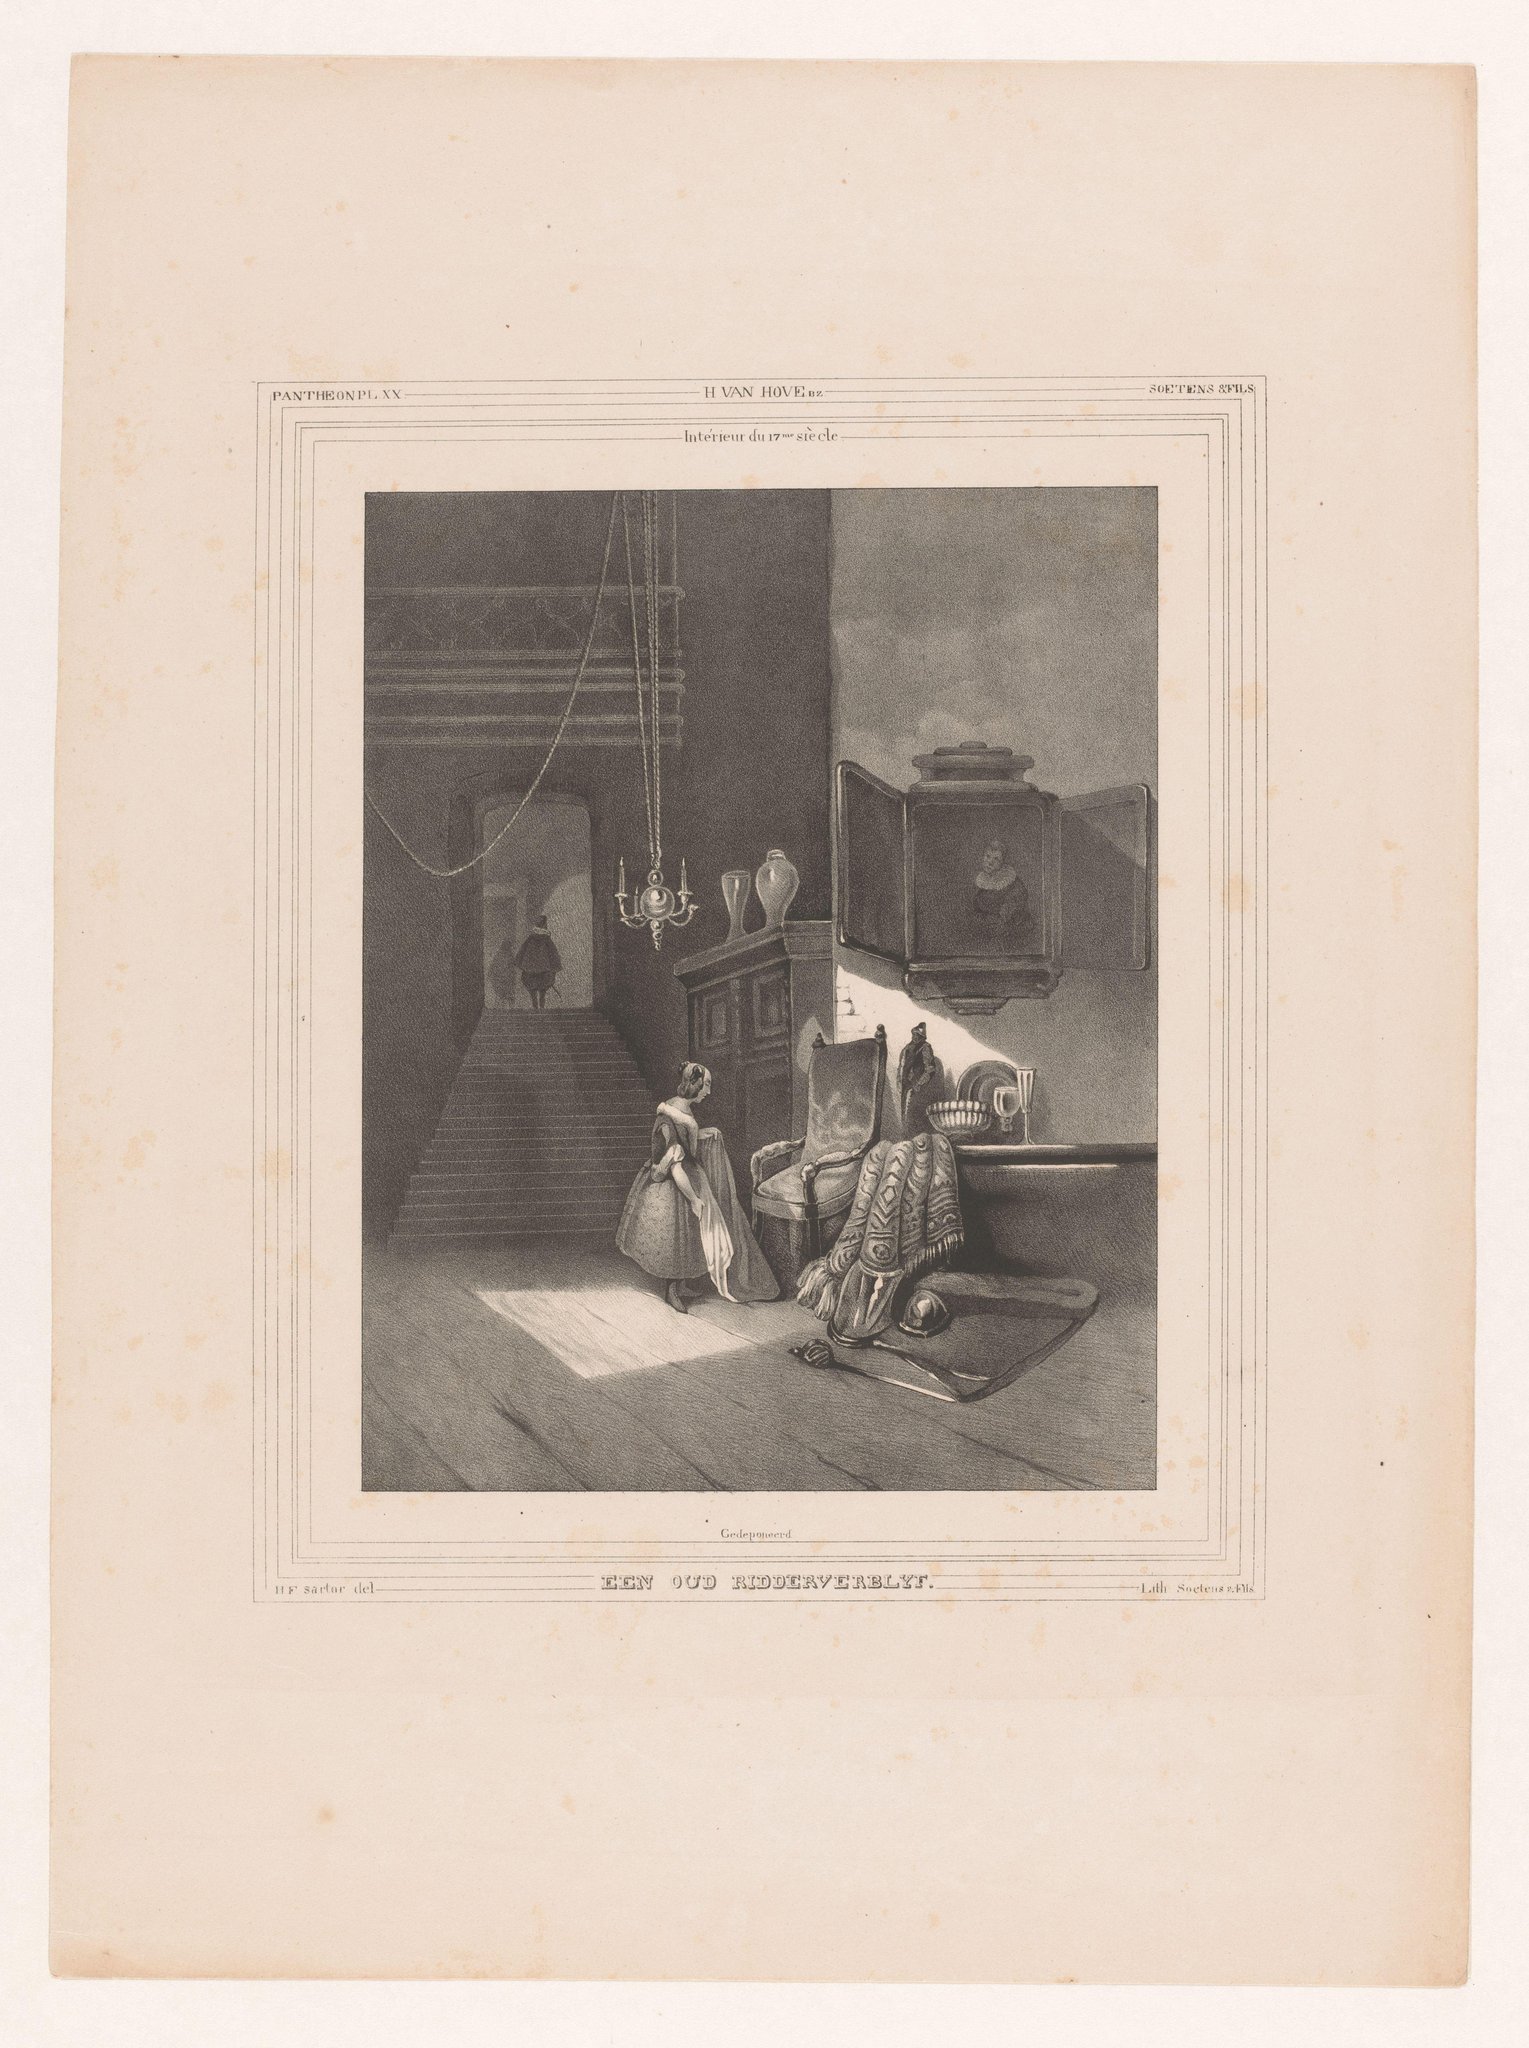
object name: print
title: Vrouw in interieur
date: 1837-1840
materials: paper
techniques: lithograph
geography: the hague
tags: interior of the house, staircase, standing figure - aa - female human figure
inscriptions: collector's mark: Lugt 2228, : ‘Gedeponeerd.’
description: Een vrouw met doek in de hand staat in een interieur bij een kast en stoel. Rechts een tafel waarop servies staat en waarboven een drieluik hangt. Links staat een man in een deuropening bovenaan een trap.